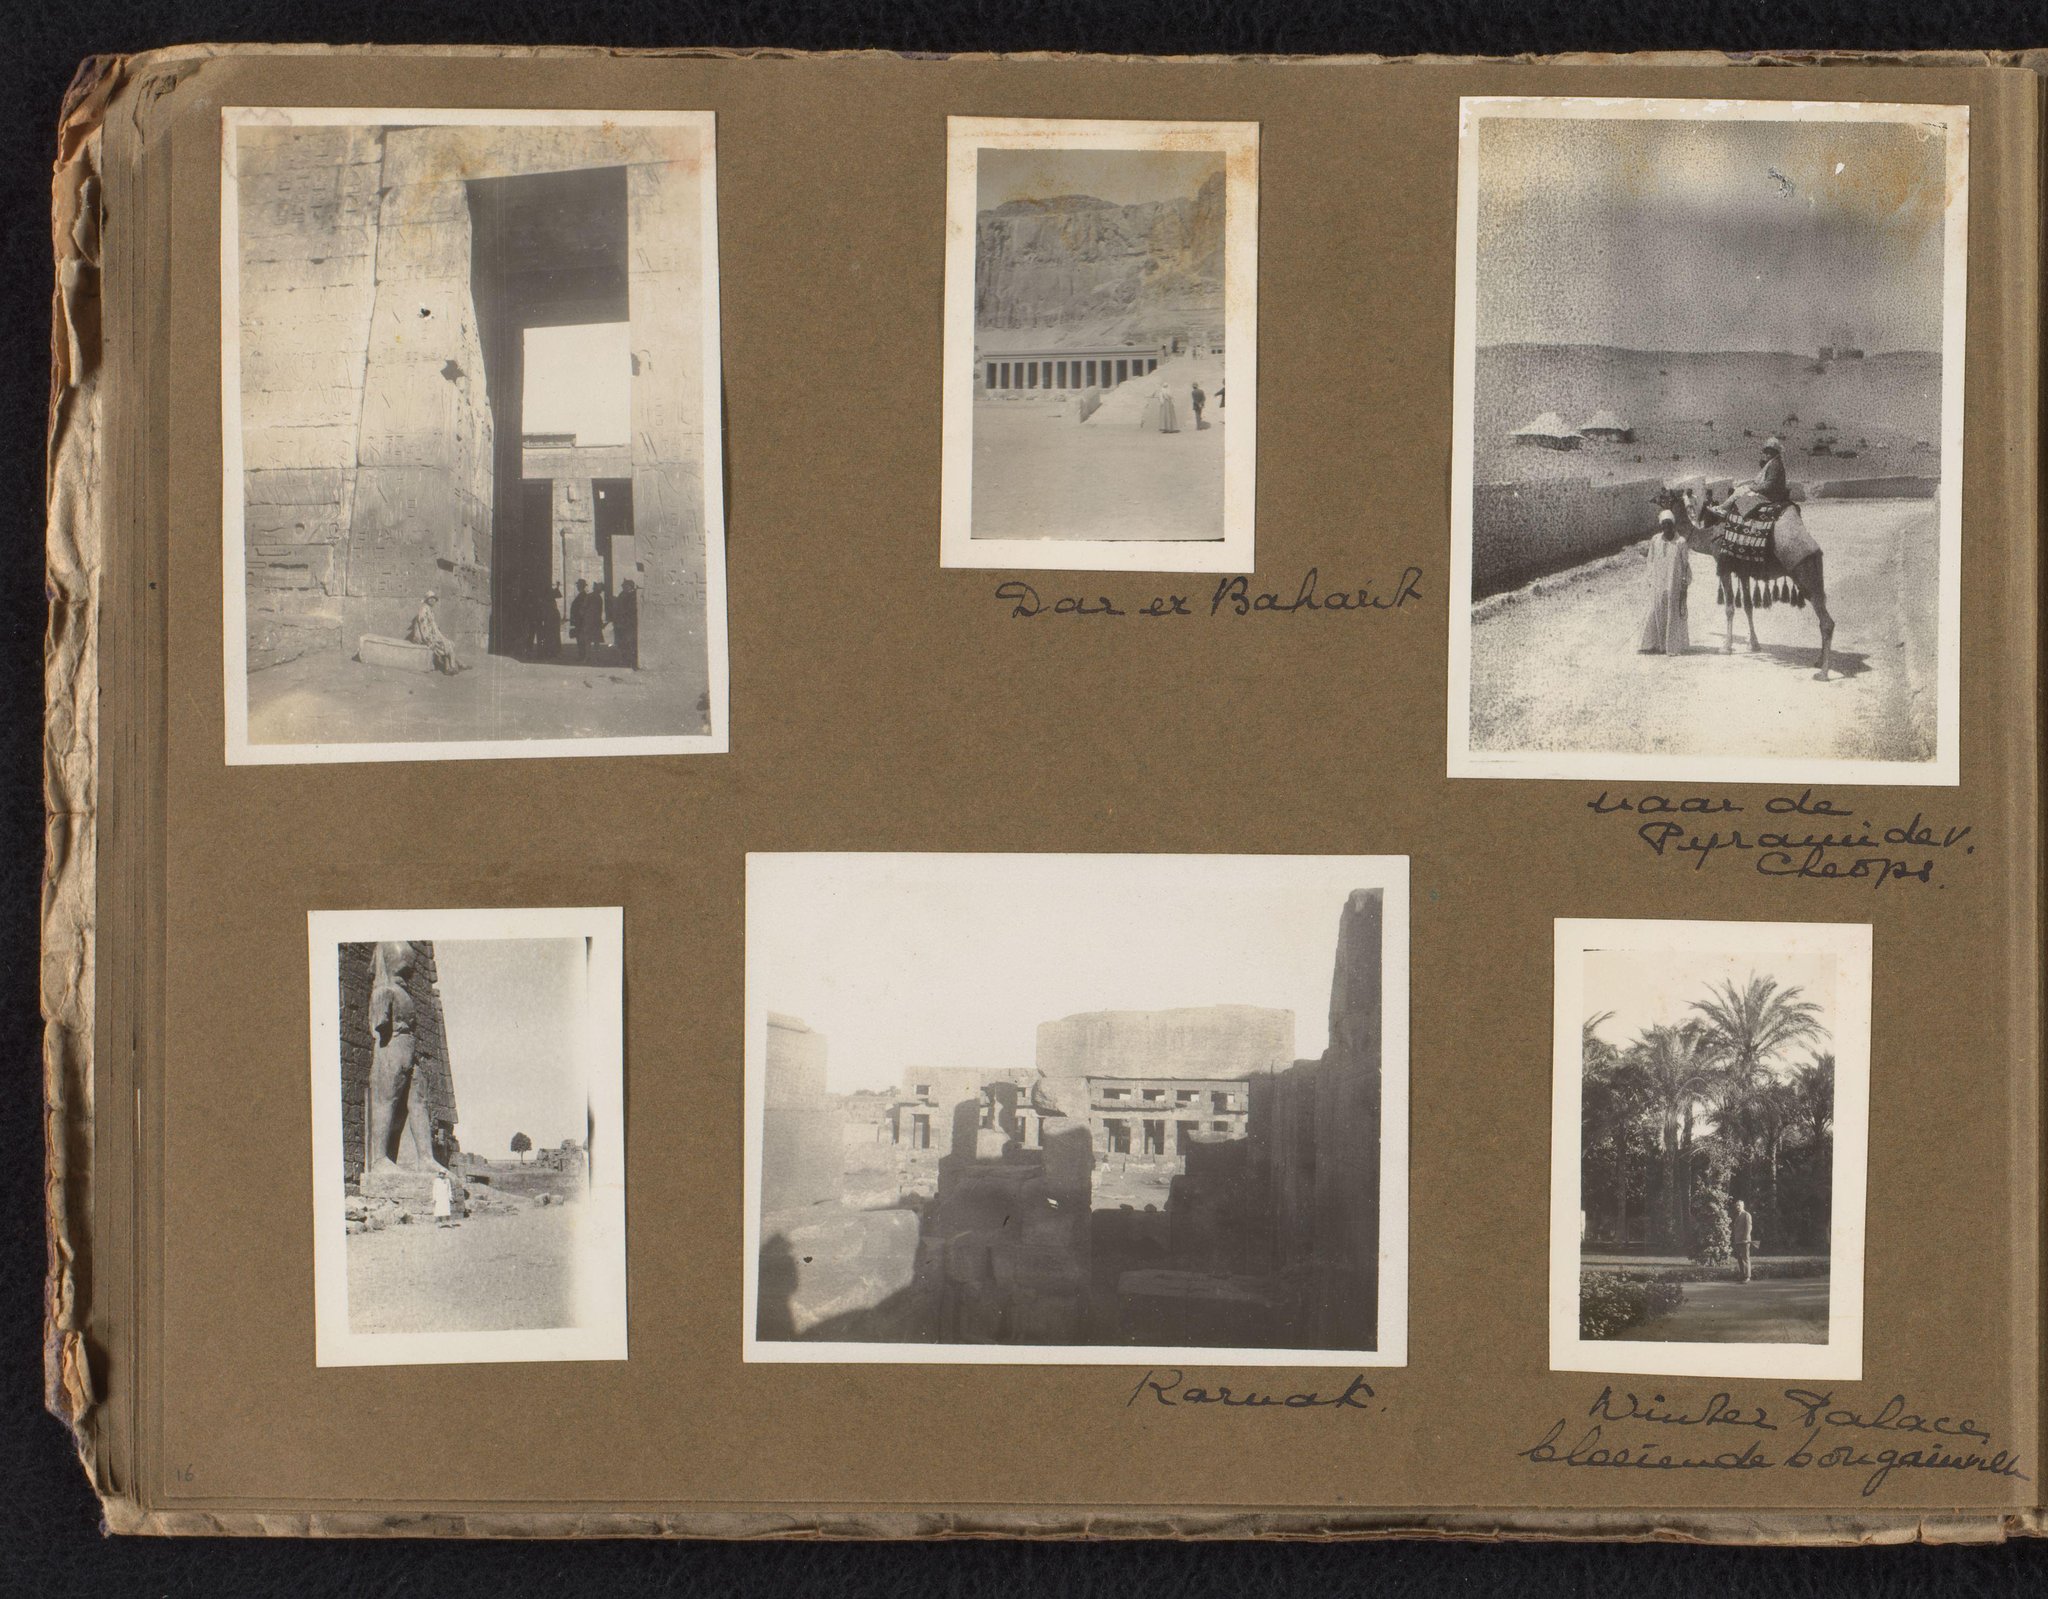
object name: album leaf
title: Zes foto's van een reis naar Egypte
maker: carolina frederika onnen (lien/loen)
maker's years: 1896-1983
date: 1903-1927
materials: paper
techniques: gelatin silver print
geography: egypt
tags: carolina frederika onnen (lien/loen), temple, shrine ~ egyptian religion, piece of sculpture, reproduction of a piece of sculpture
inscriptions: inscription: ‘Karnak’, inscription: ‘naar de/ Pyramide v./ Cheops’, inscription: ‘Winter palace/ bloeiende bougainville’, inscription: ‘Dar er Bahari’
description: Deze foto's maken deel uit van een album.